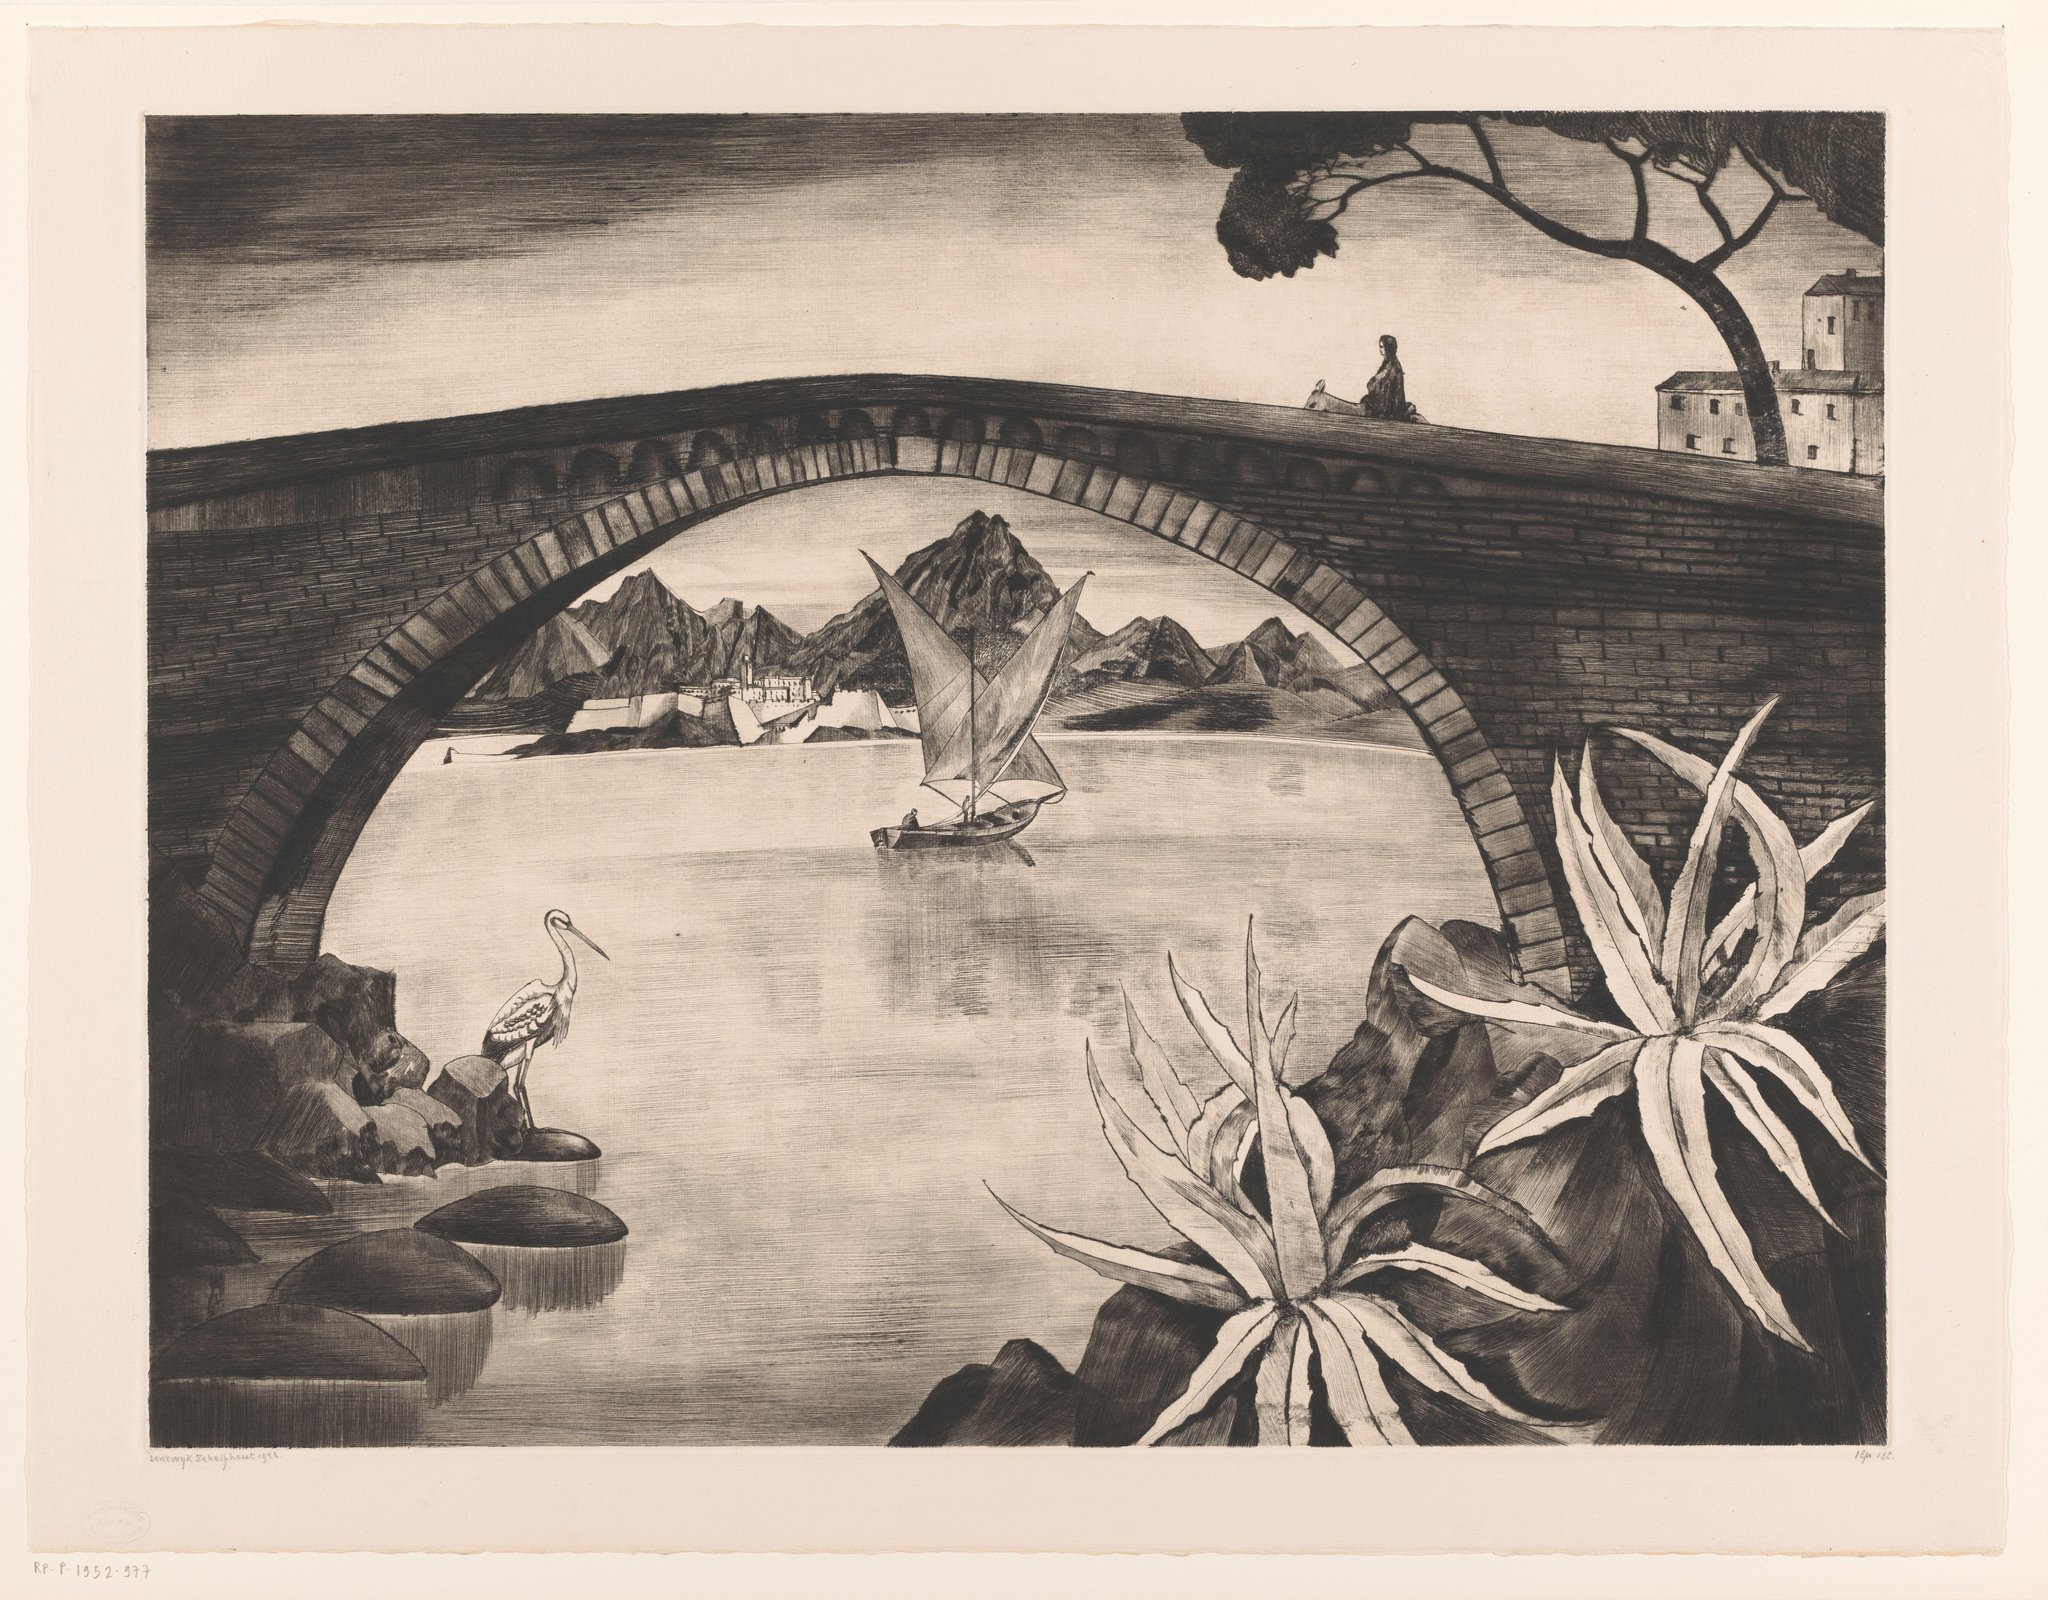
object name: print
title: Le Grand pont Corse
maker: lodewijk schelfhout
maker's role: draughtsman, print maker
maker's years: 1881-1943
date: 1922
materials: paper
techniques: drypoint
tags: riding a horse, ass, or mule; rider, horseman, shore-birds and wading-birds: heron, landscapes with waters, waterscapes, seascapes (in the temperate zone), bridge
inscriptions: collector's mark: Lugt 2760, collector's mark: Lugt 2228, collector's mark: Lugt 5i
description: Er rijdt een vrouw op een ezel over de brug. Bij de voet van de brug bevinden zich planten en een reiger. Onder de brug door is er zicht op een zeilschip, een ommuurde nederzetting en bergen.